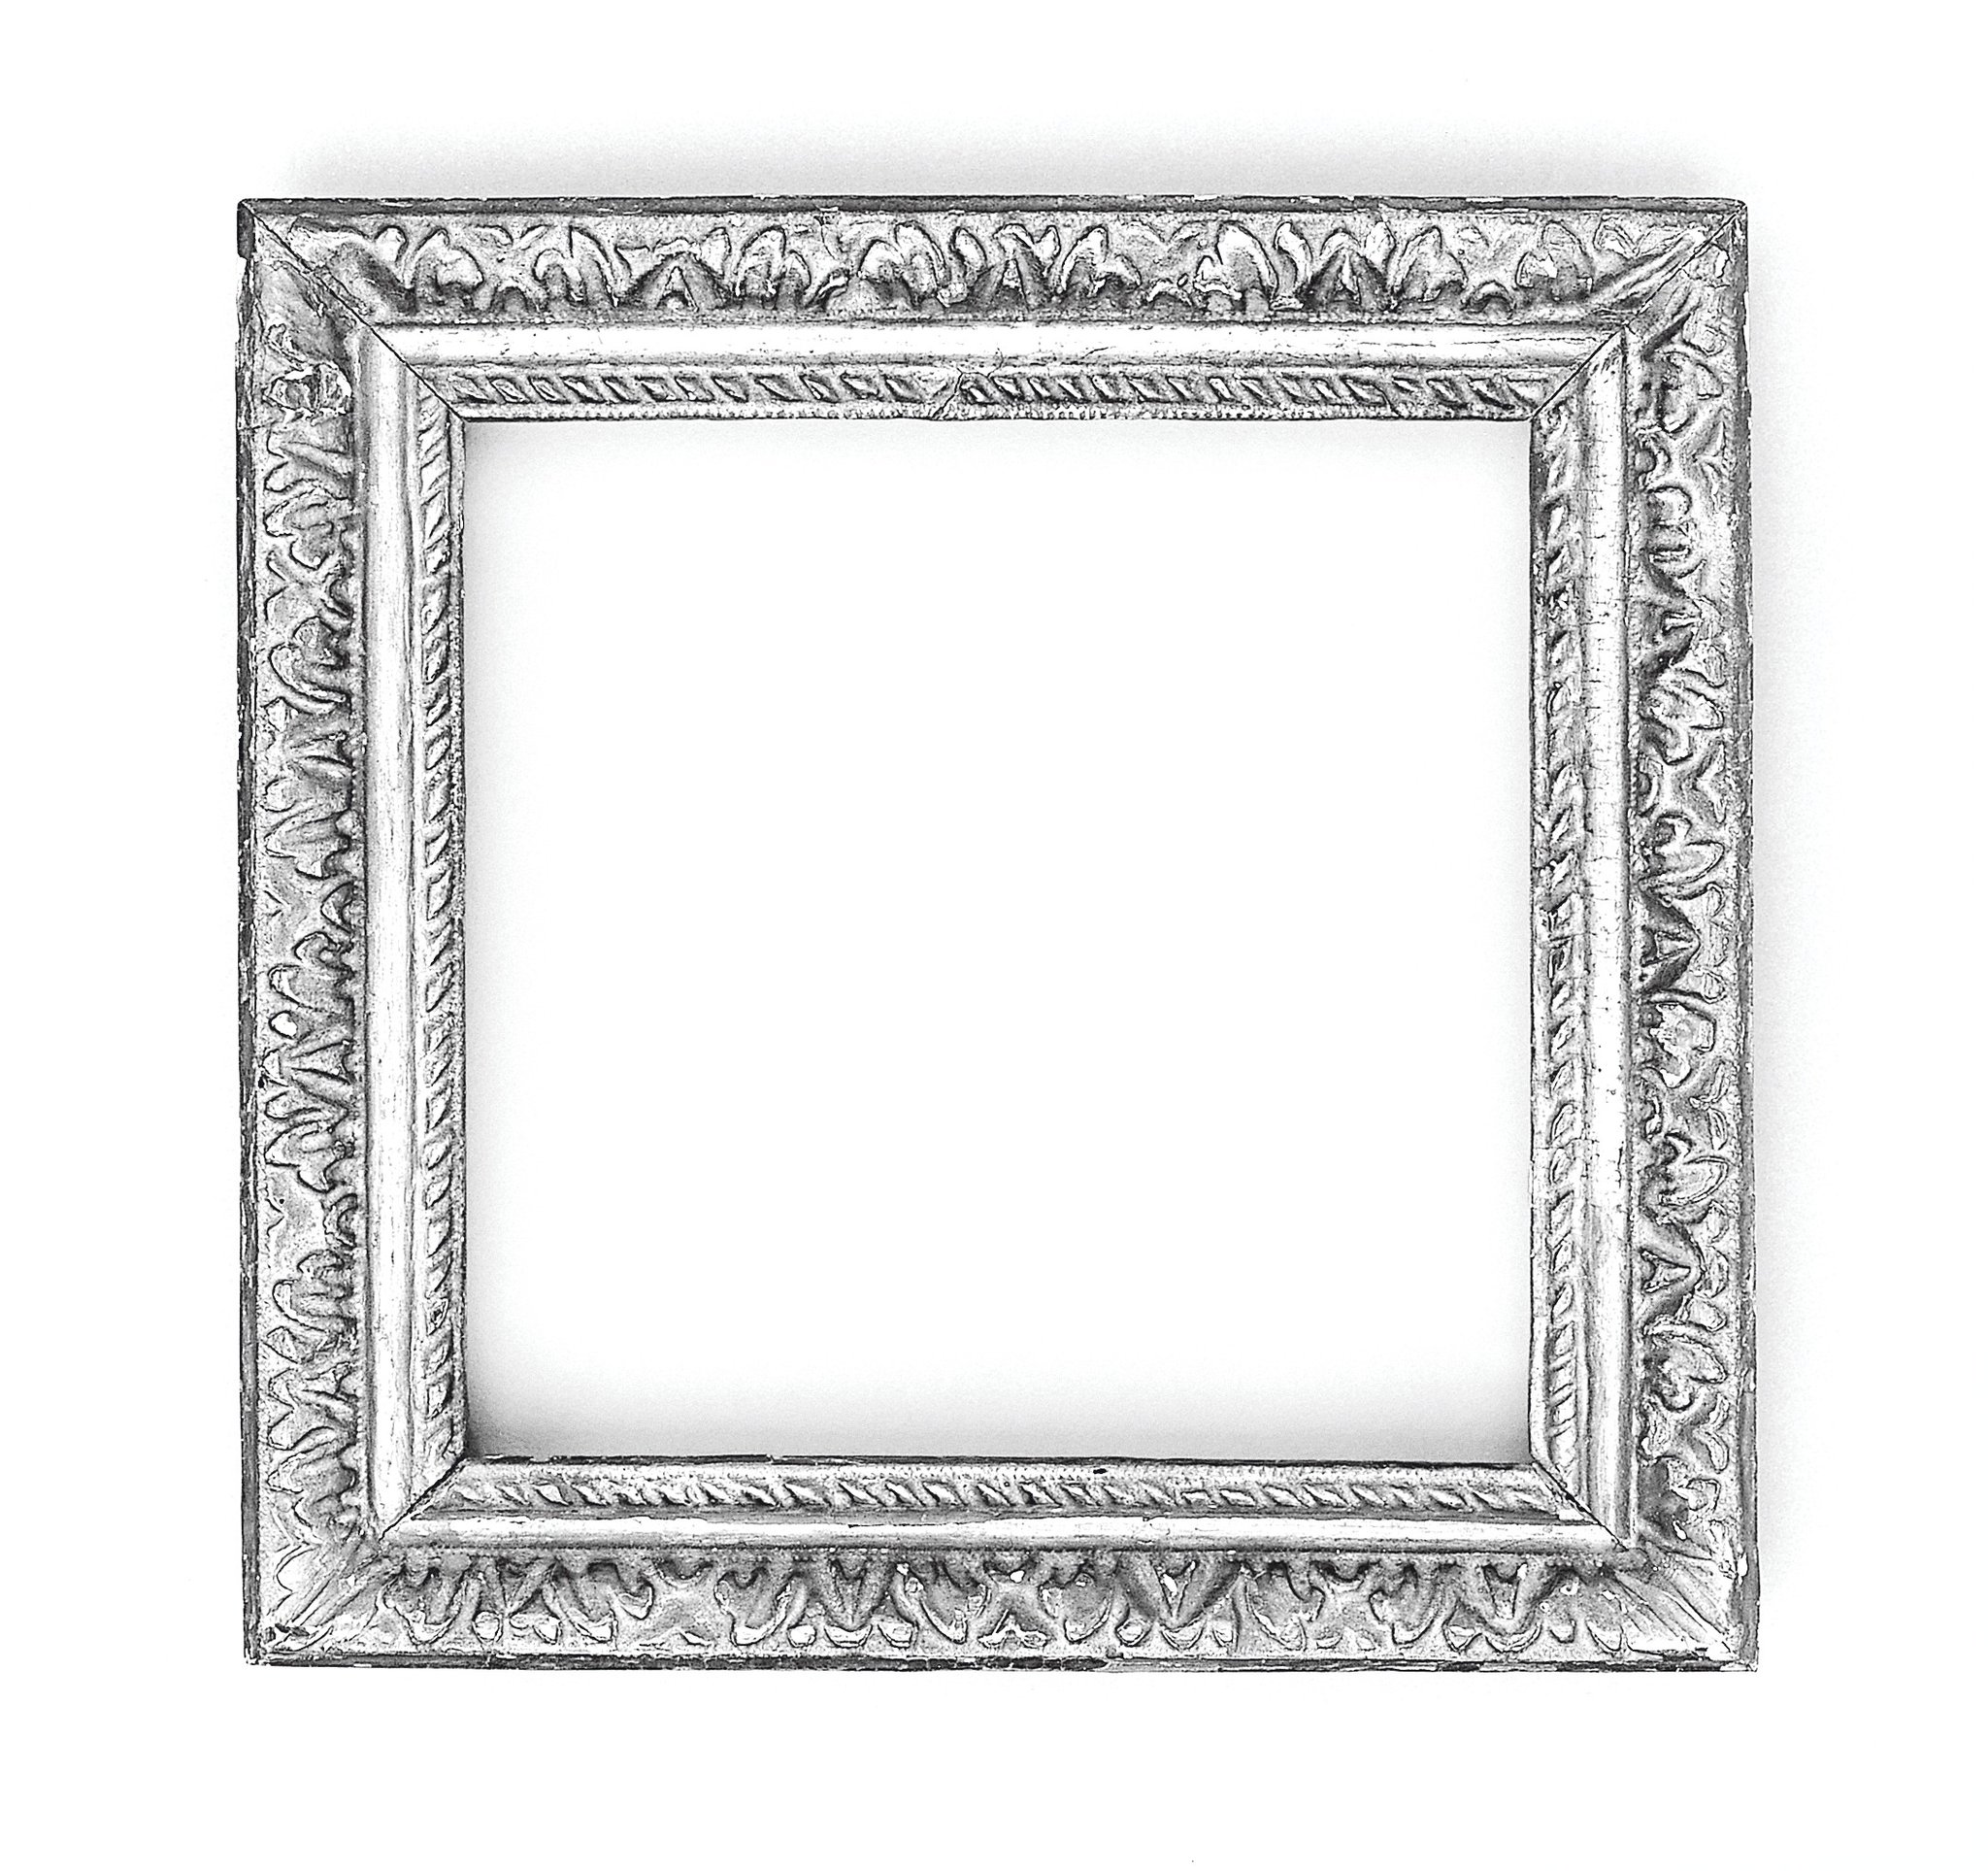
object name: frame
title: Ovolo frame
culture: french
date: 1650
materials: wood